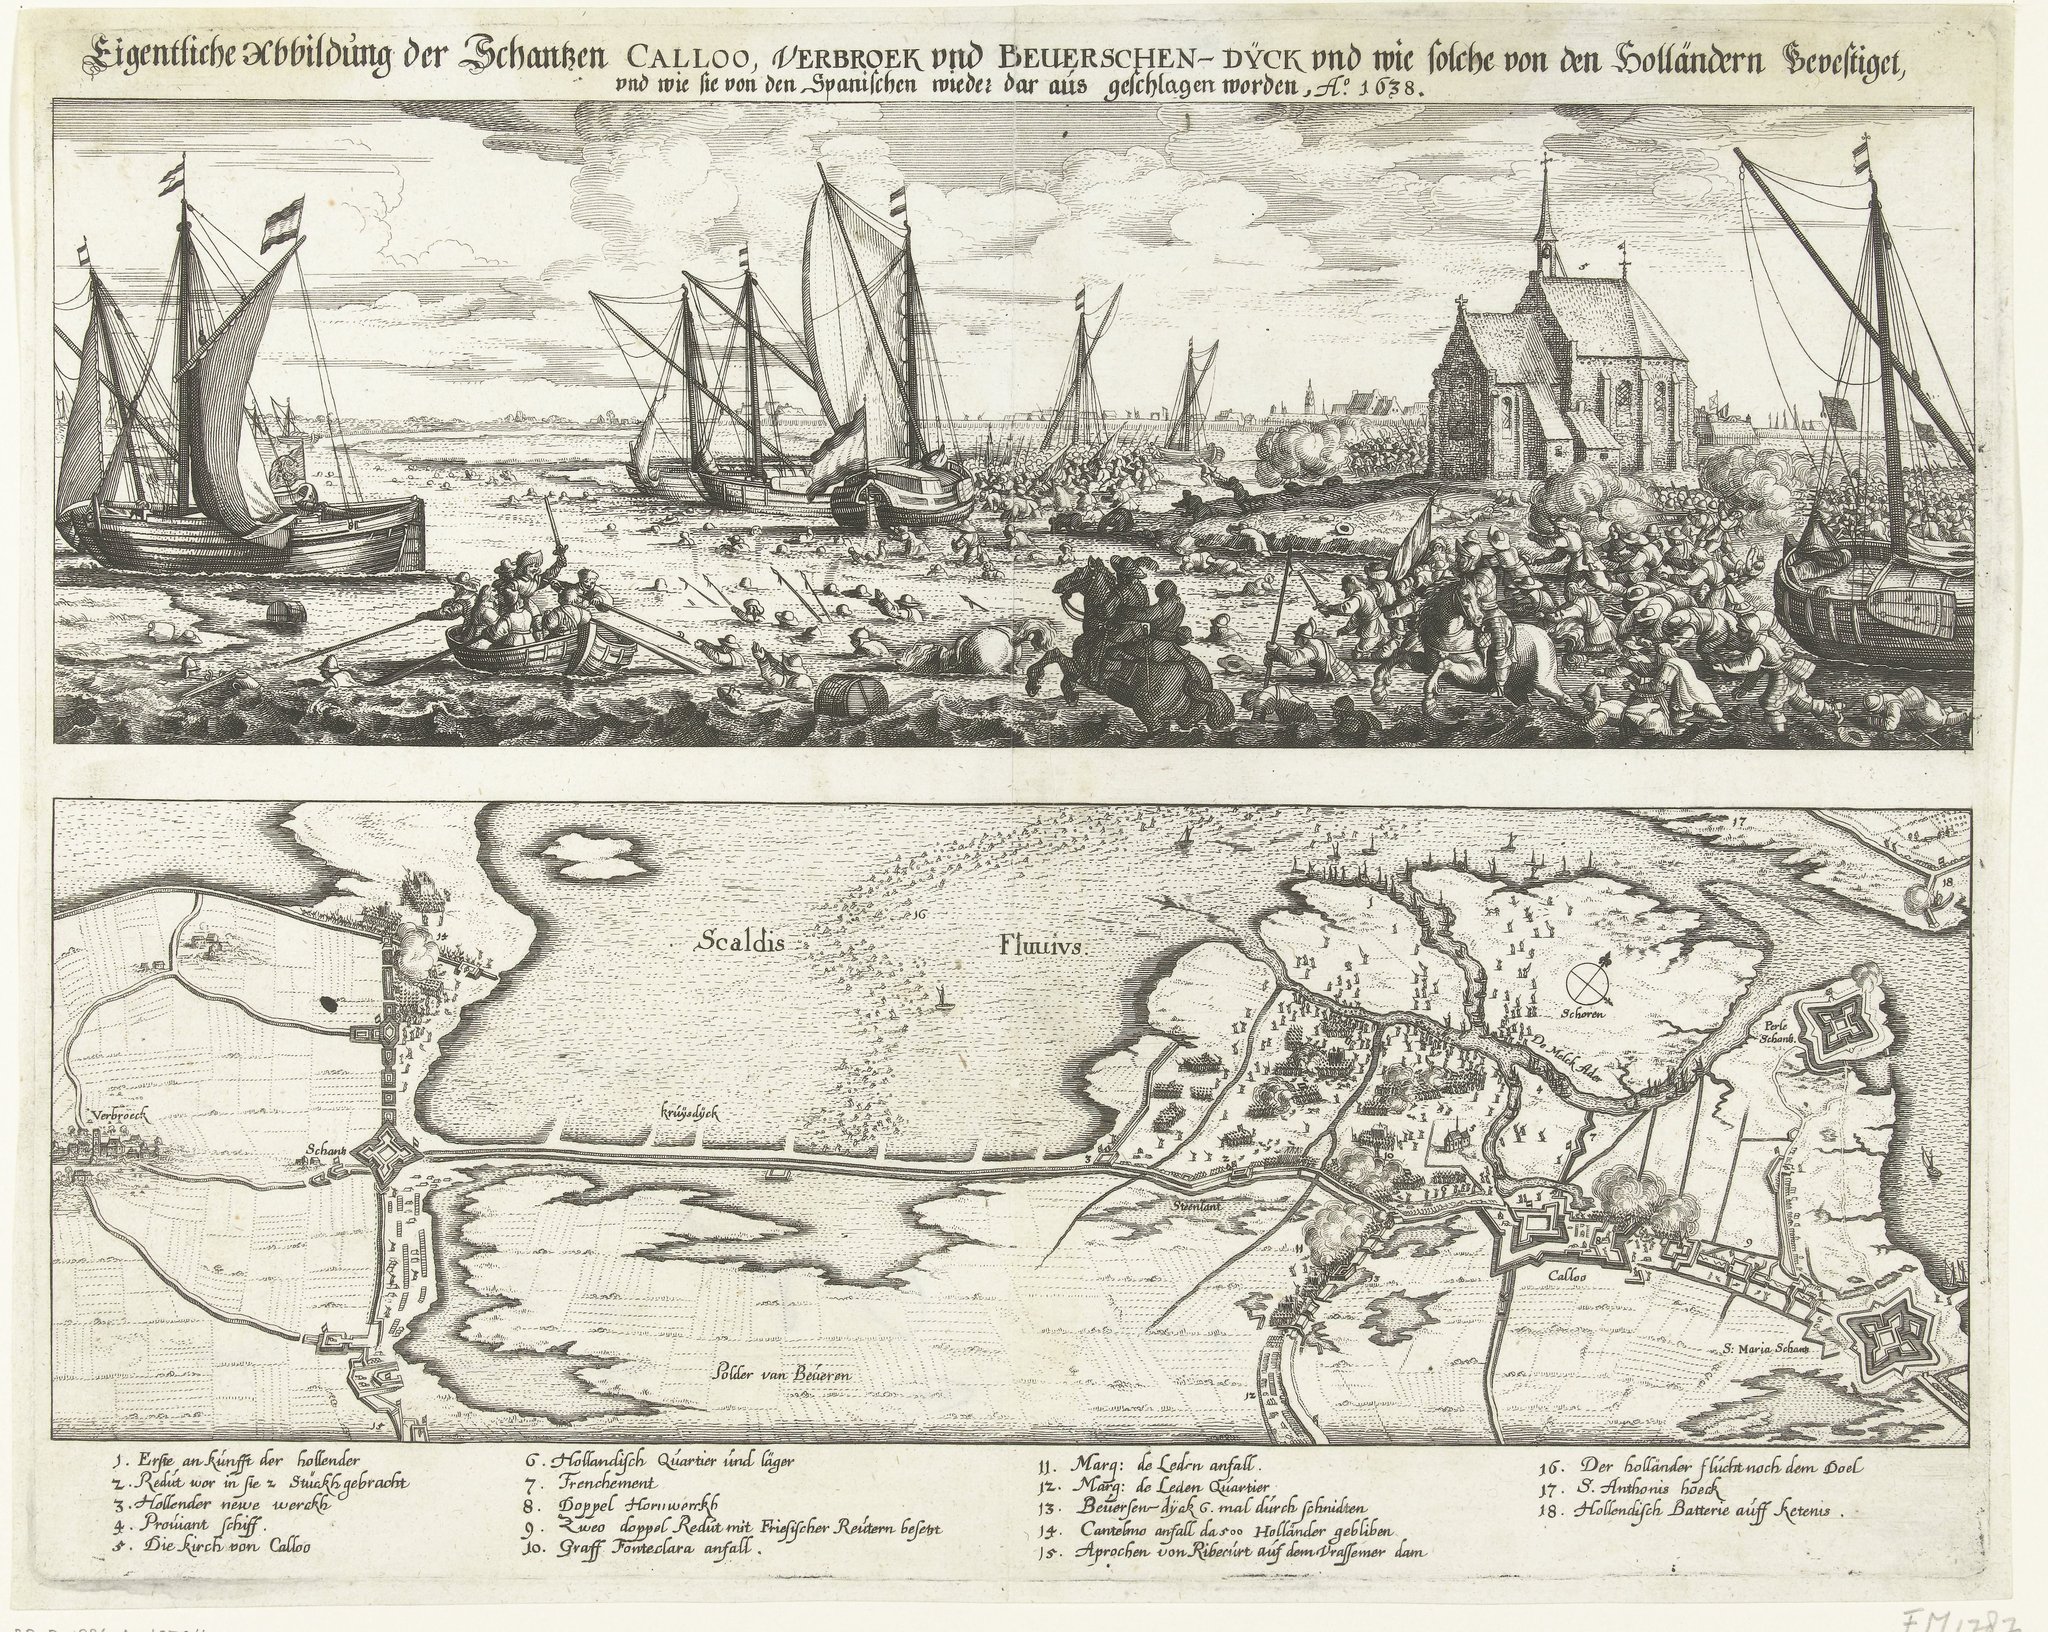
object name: print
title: Eigentliche Abbildung der Schantzen Calloo, Verbroek und Beverschen-Dyck und wie solche von den Holländern bevestiget, und wie sie von den Spanischen wieder dar aus geschlagen worden, Ao. 1638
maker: Anonymous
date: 1638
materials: paper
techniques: etching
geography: germany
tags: maps of separate countries or regions, (military) attack, putting the enemy to flight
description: Blad met twee voorstellingen. Boven de vluchtende soldaten van het Staatse leger onder graaf Willem van Nassau-Siegen na de mislukte aanval op de schans bij Kallo, 21 juni 1638. De soldaten proberen door het water de gereedstaande boten te bereiken. Rechts het kerkje van Kallo. Onder een kaartje van de Kruisdijk aan de Schelde en de gevechten rond fort Kallo. In de plaat onder de voorstellingen de legenda 1-18 in het Duits.